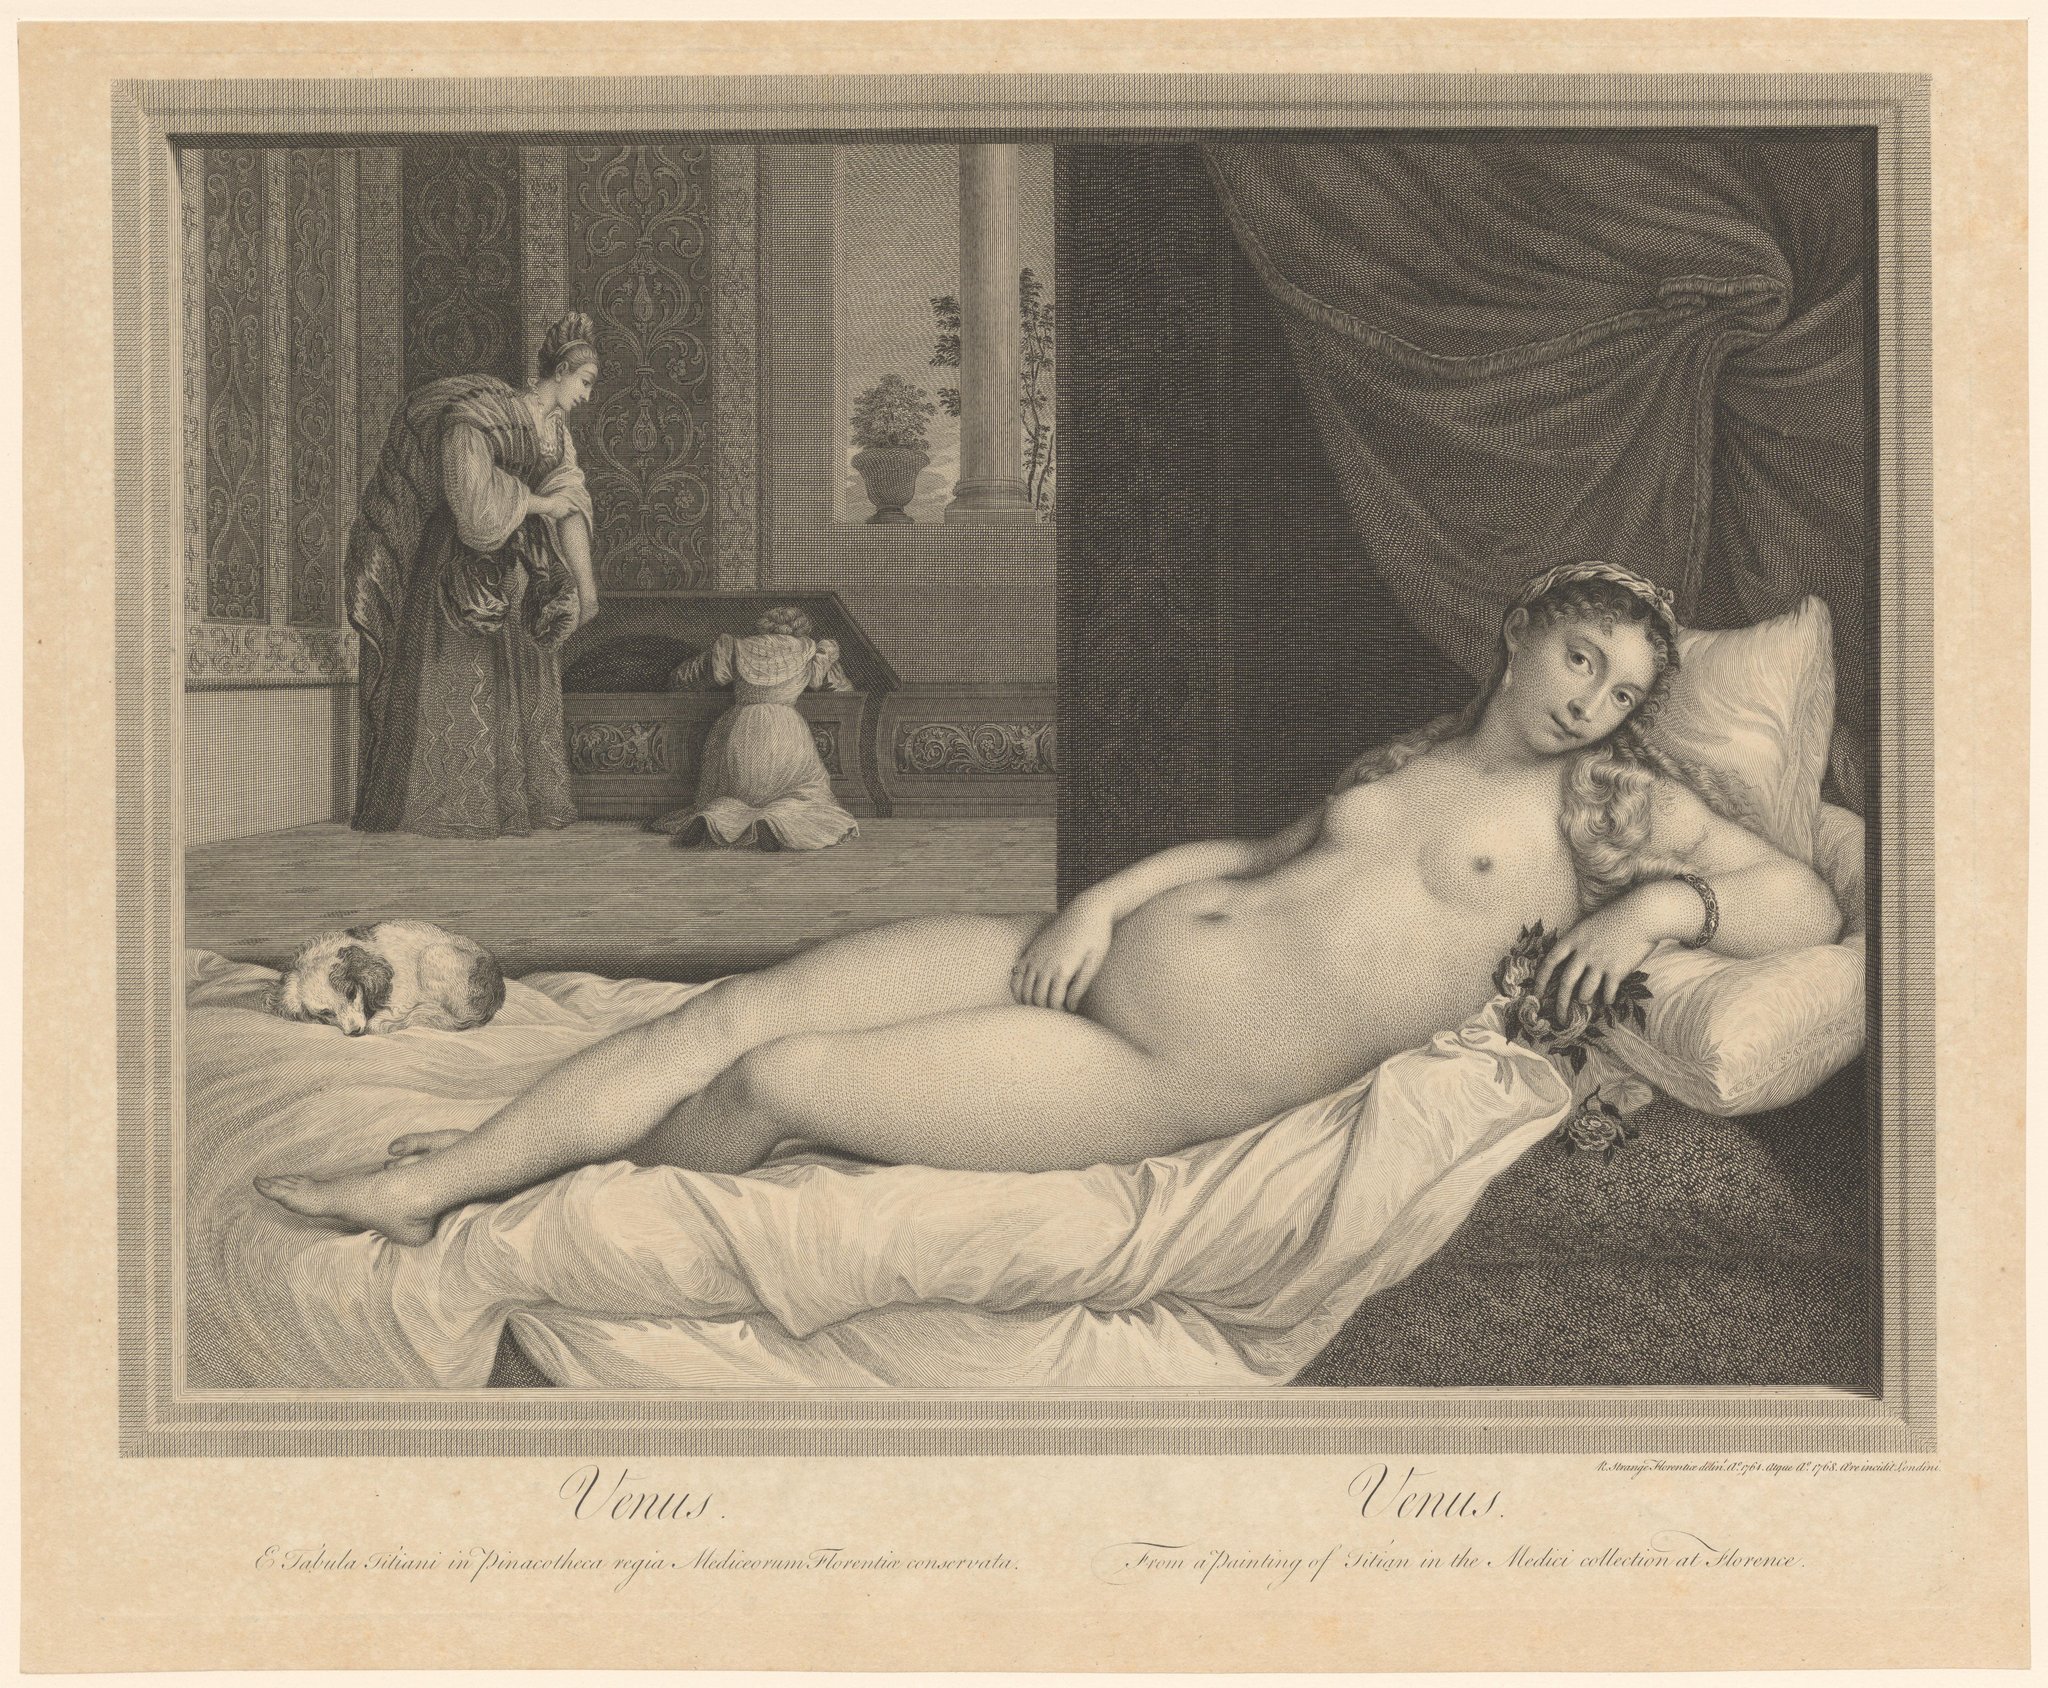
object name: print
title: Venus van Urbino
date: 1768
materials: paper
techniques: engraving, etching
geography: london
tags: (story of) venus (aphrodite)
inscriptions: collector's mark: Lugt 2228